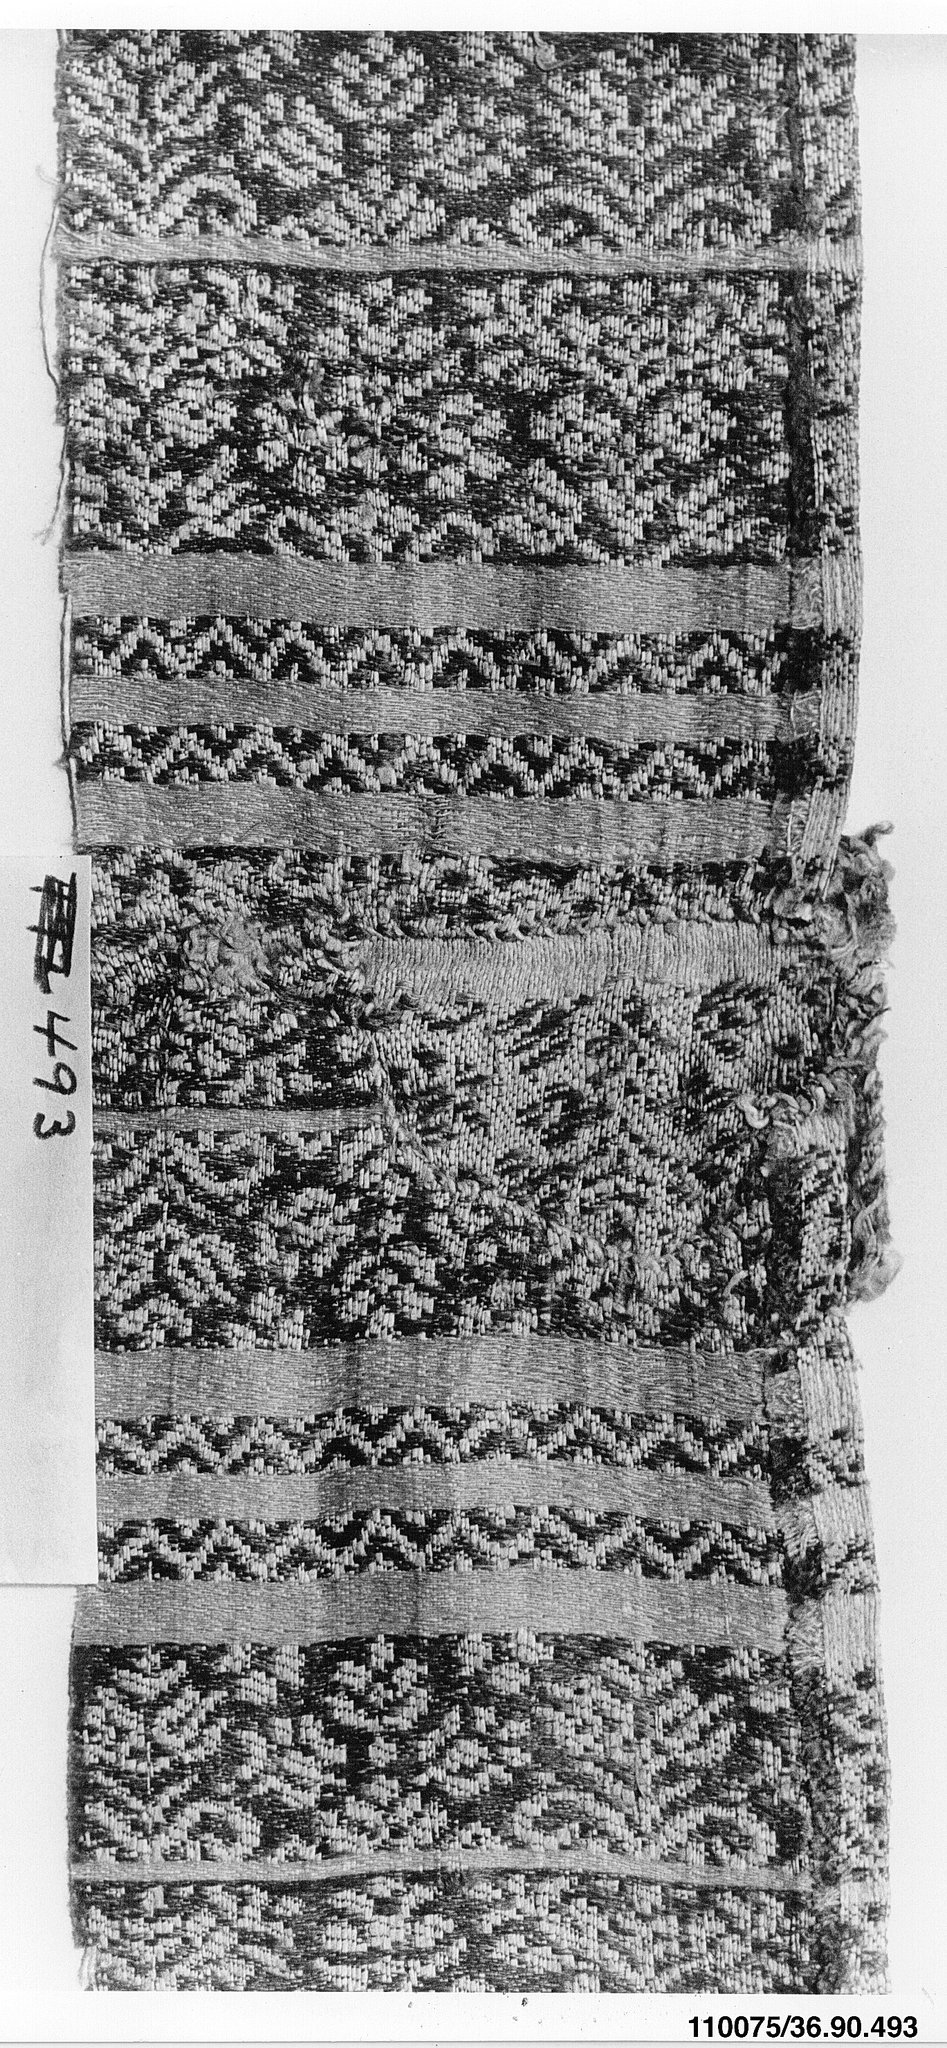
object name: piece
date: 1501-1700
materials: linen, silk